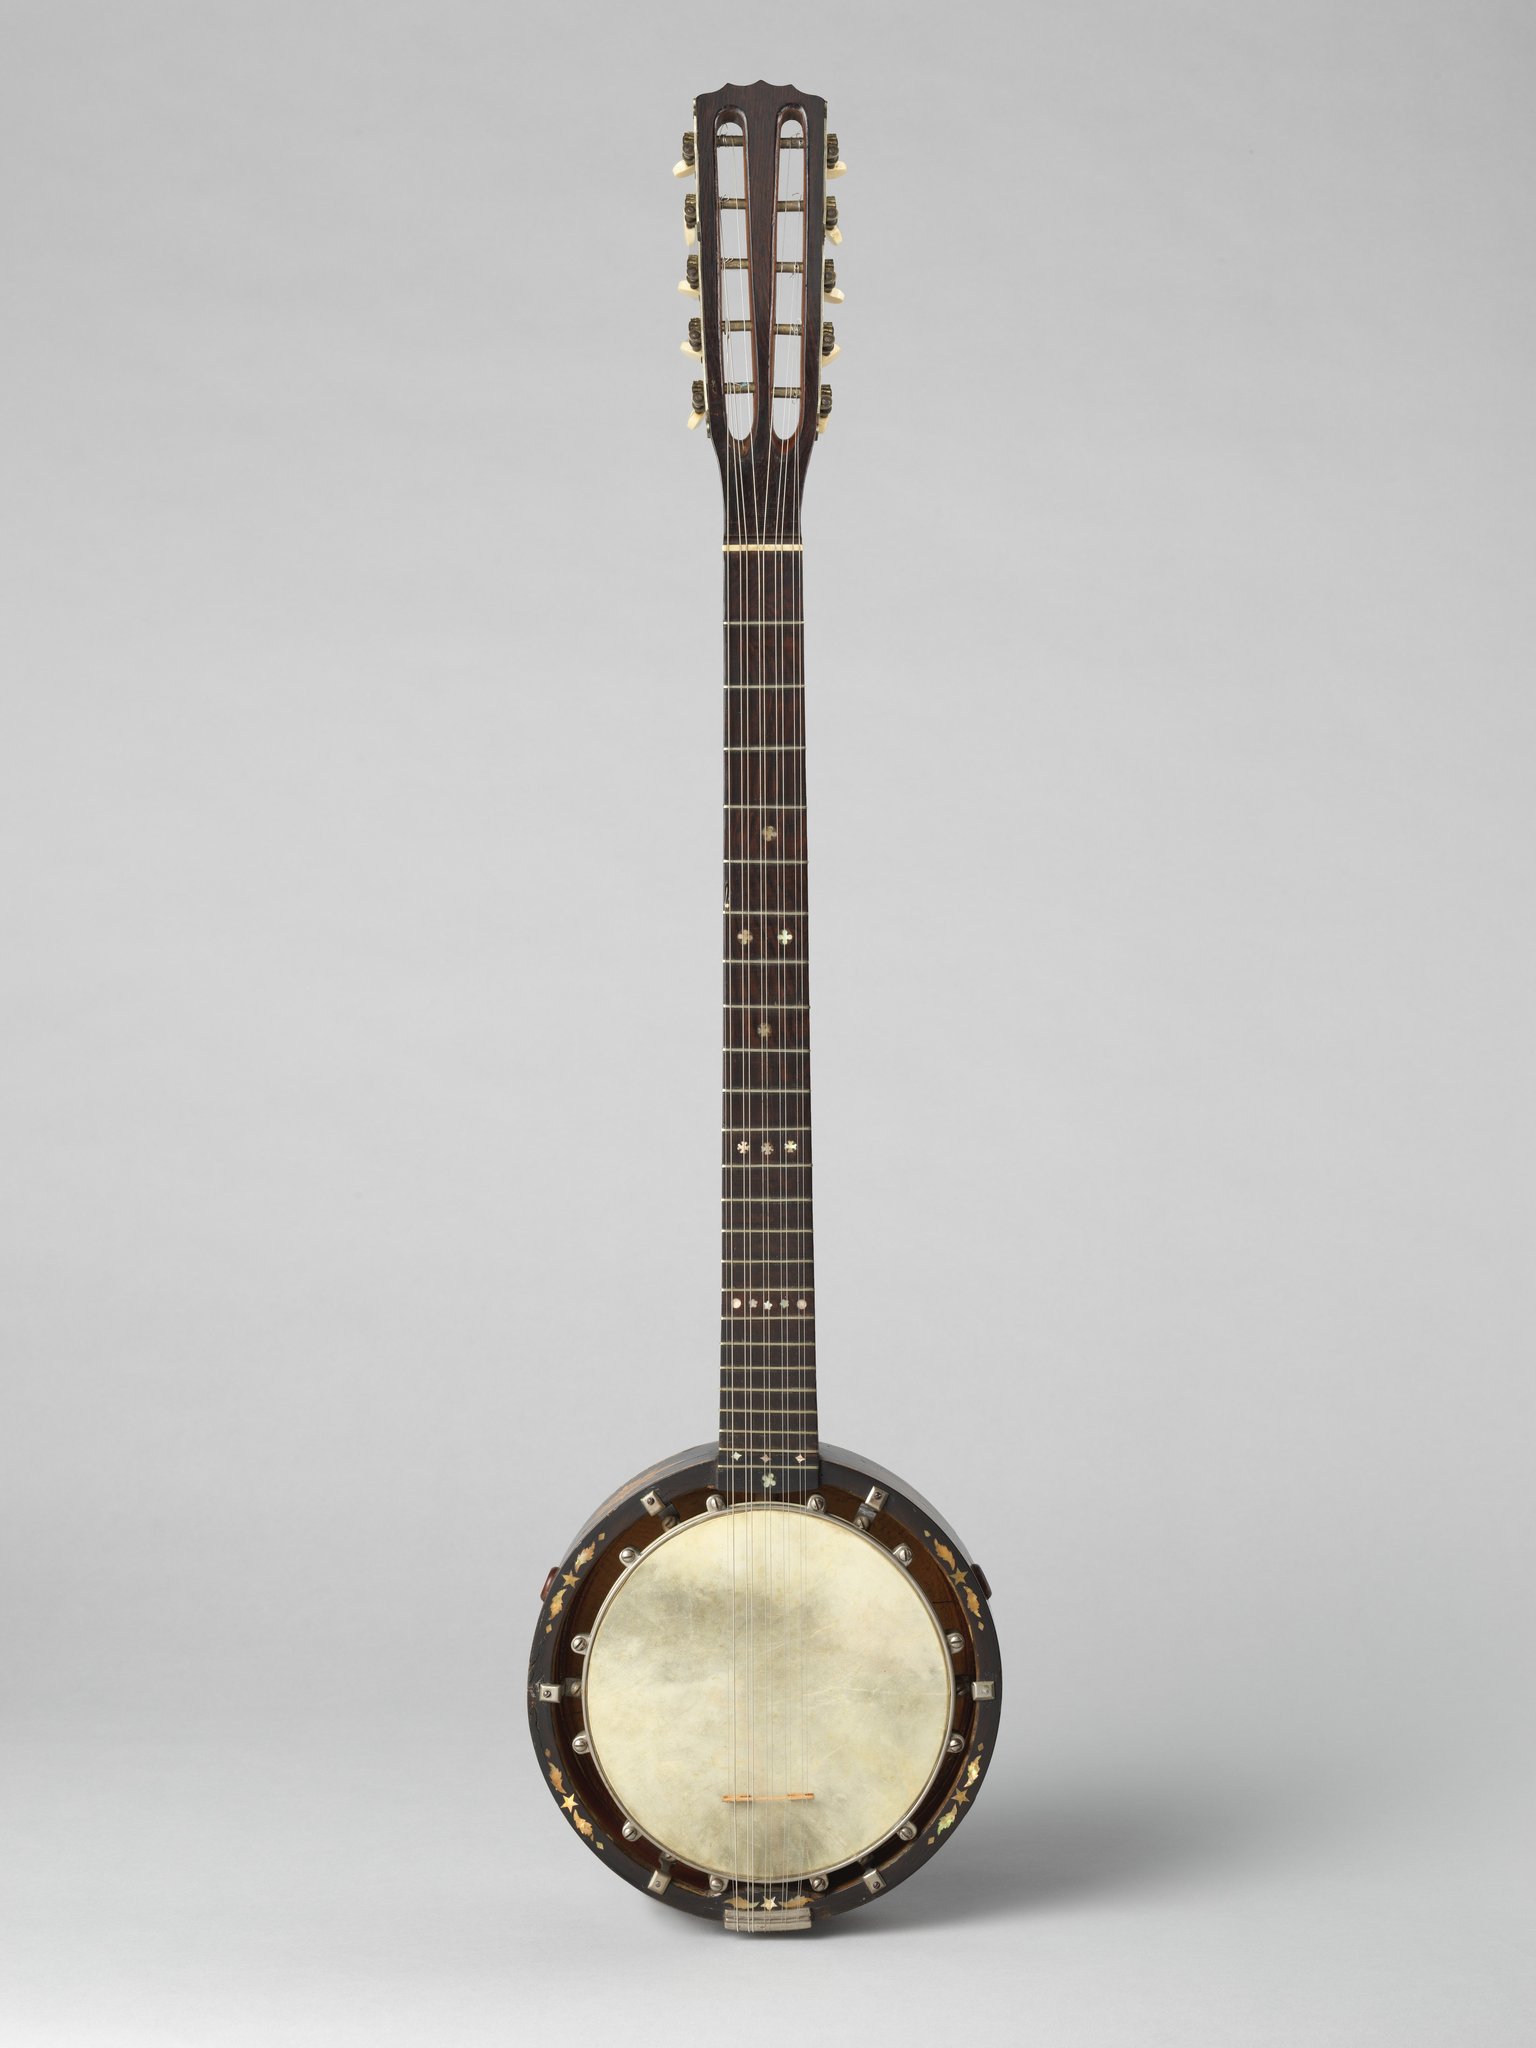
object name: banjo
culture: american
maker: benjamin bradbury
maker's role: maker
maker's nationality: american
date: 1885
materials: metal, wood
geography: united states